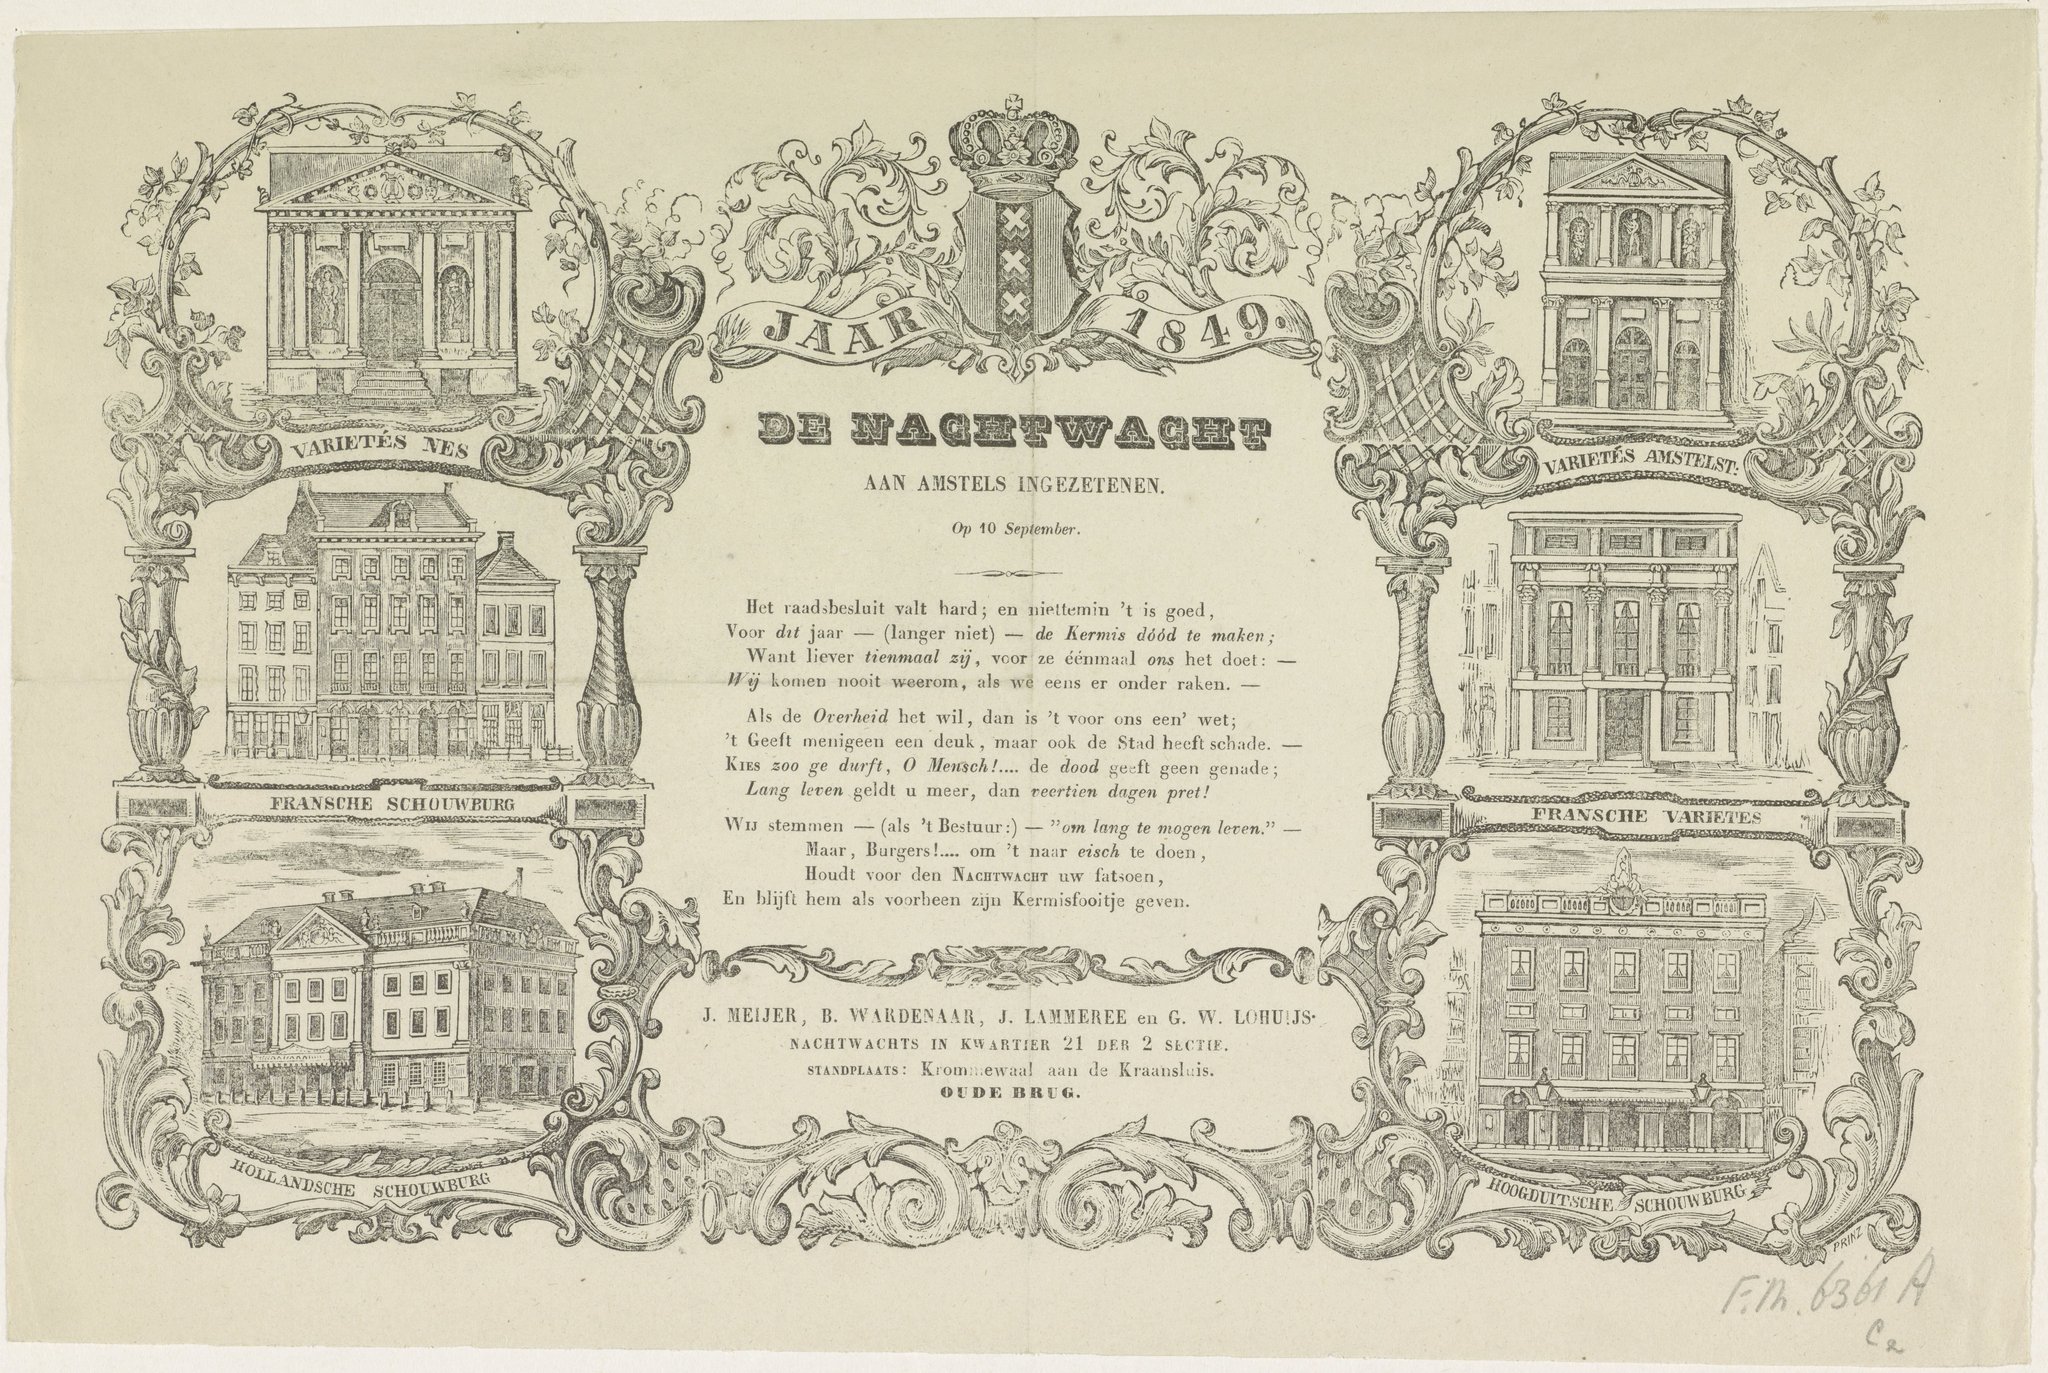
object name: fair print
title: Kermisprent van de Amsterdamse nachtwacht voor het jaar 1849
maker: friedrich robert prinz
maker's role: print maker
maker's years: 1820-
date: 1849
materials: paper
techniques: letterpress printing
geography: netherlands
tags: night patrol, theatre (building), amsterdam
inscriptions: collector's mark: Lugt 2228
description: Kermisprent van de Amsterdamse nachtwacht (ratelwacht), 10 september 1849. Tussen bladeren en ranken afbeeldingen van: de Variété aan de Nes, de Franse Schouwburg, de Hollandse Schouwburg, de Oude Salon de Variété in de Amstelstraat, de Franse Variétés en de Hoogduitse schouwburg. Met een vers in drie delen. Namens de nachtwacht in kwartier No. 21 van de 2e sectie: J. Meijer, B. Wardenaar, J. Lammeree en G.W. Lohuijs.